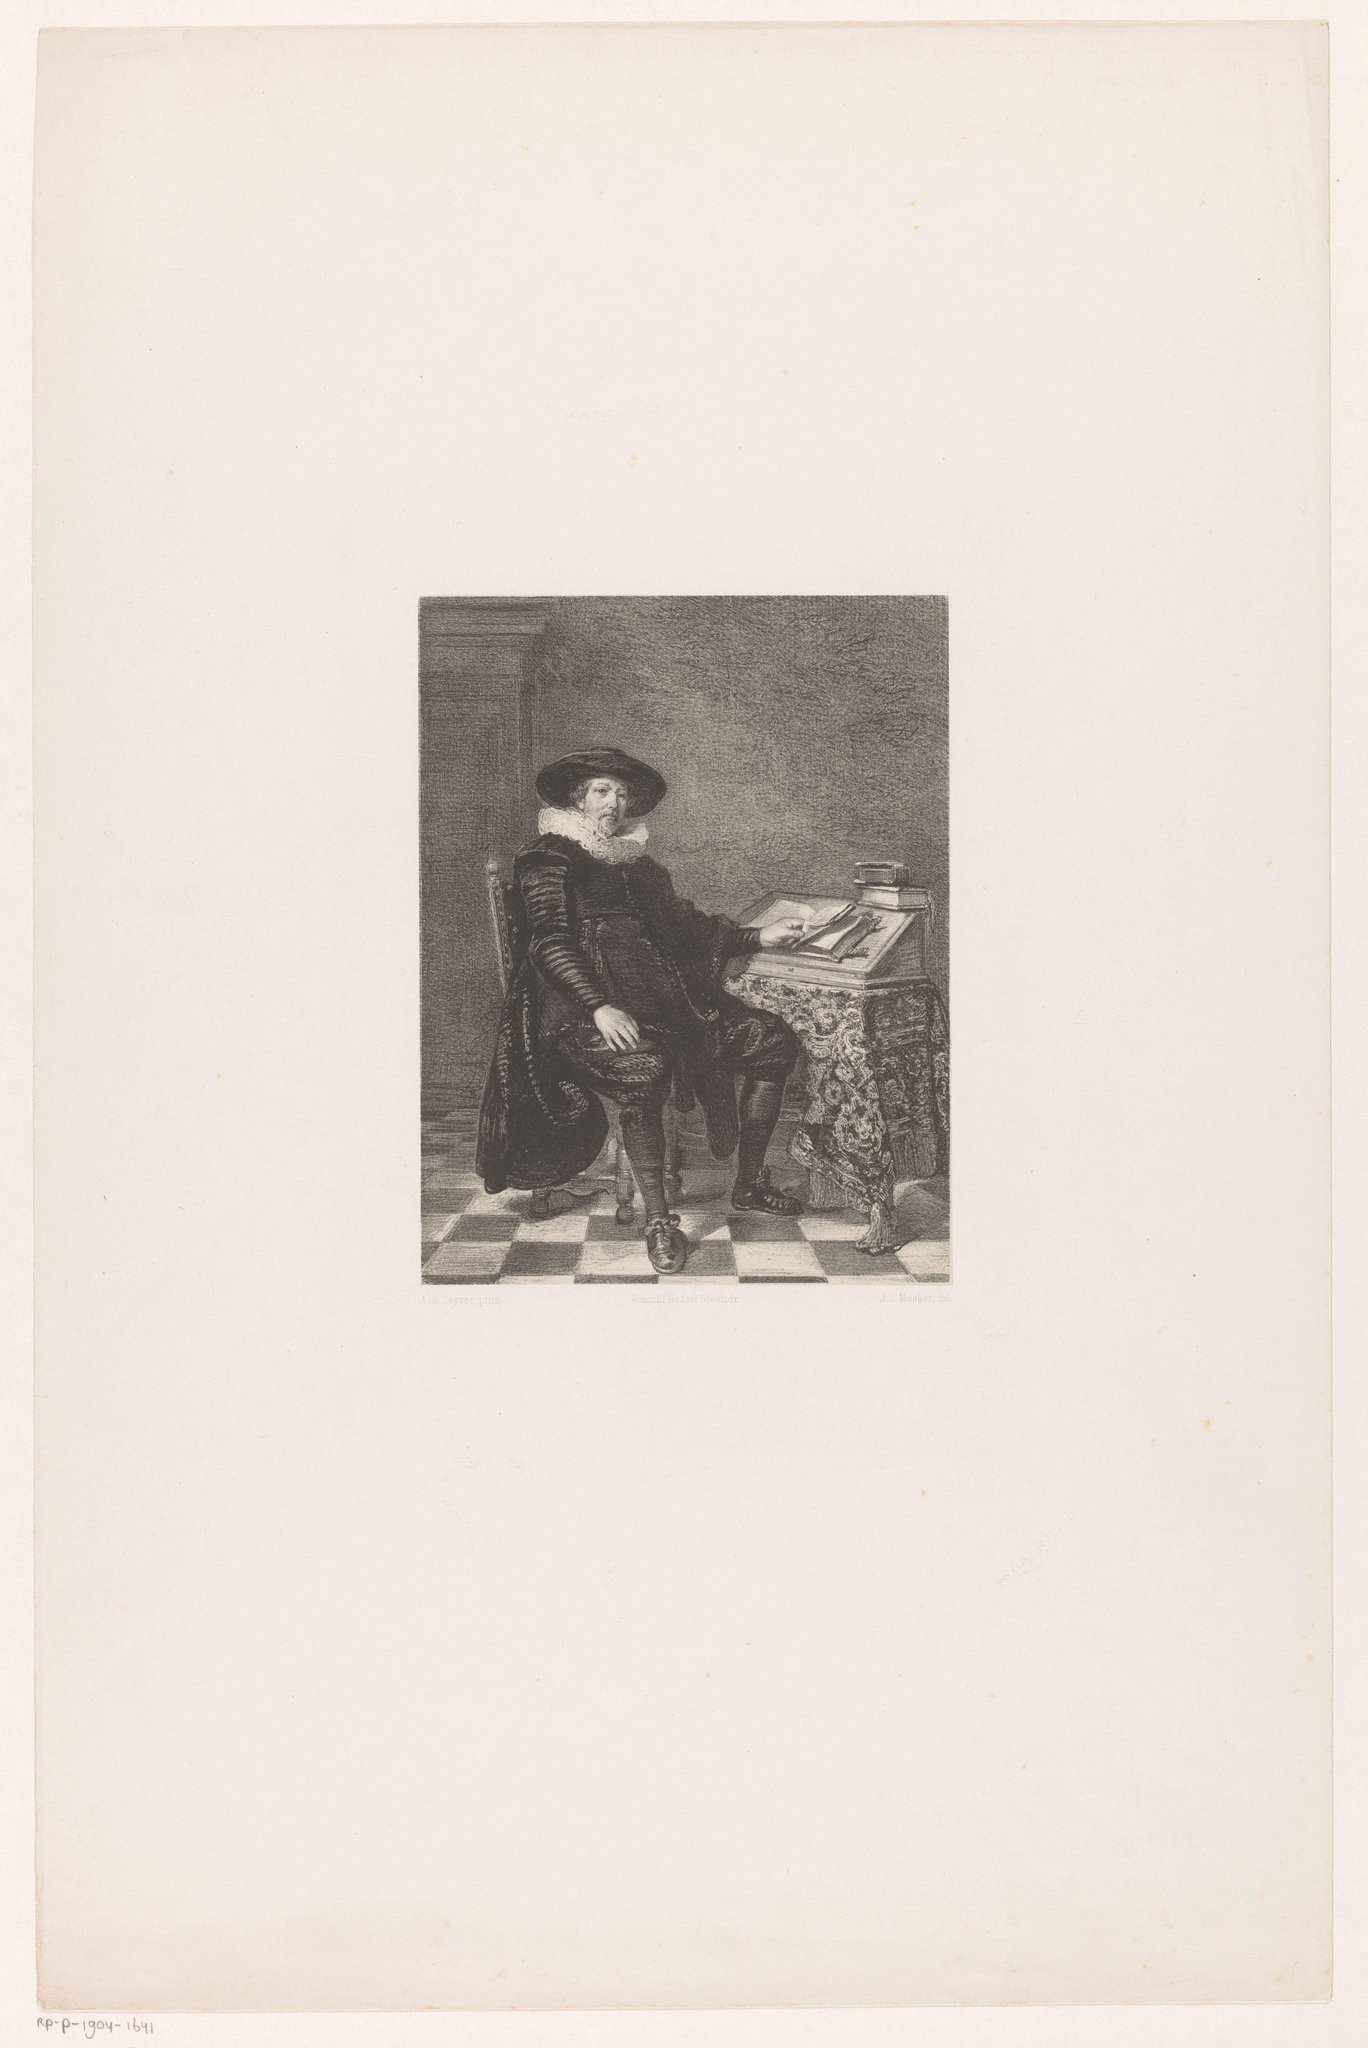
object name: print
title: Portret van een geleerde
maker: jan mesker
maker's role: print maker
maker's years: 1843-1890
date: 1867-1874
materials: paper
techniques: lithograph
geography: the hague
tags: scholar, philosopher, lectern ~ reading, historical persons (+ full length portrait), neck-gear: collar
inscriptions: collector's mark: Lugt 2228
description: De man draagt een mantel, plooikraag en hoed. Met zijn linkerhand bladert hij door een boek dat op een lessenaar ligt.